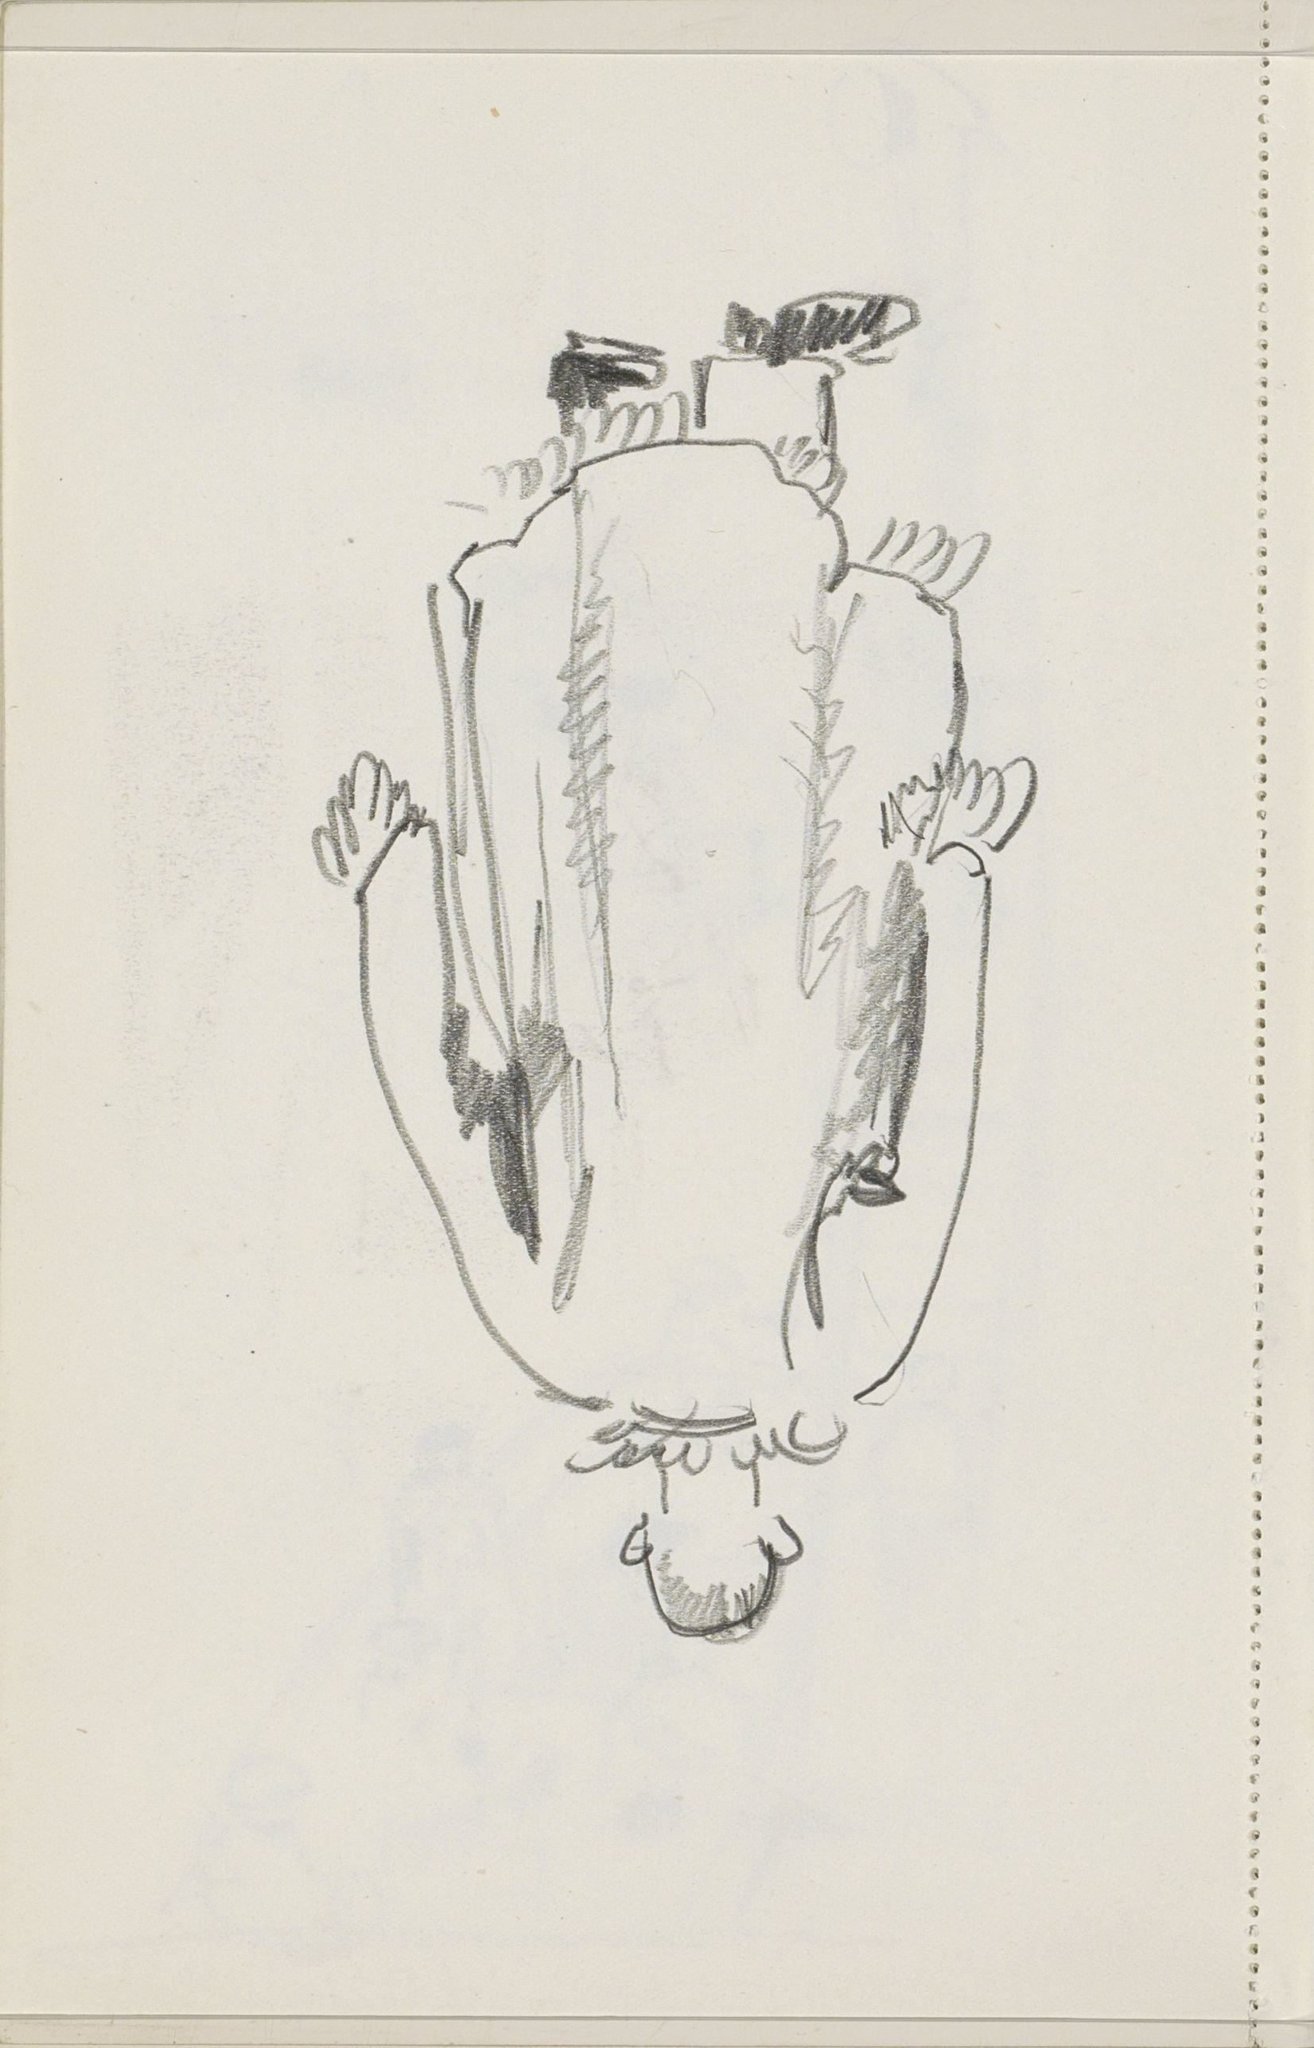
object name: sketchbook leaf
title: Staande man in een enkellange overjas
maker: cornelis vreedenburgh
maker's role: draughtsman, print maker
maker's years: 1880-1946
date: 1935-1936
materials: paper, pencil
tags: standing figure, coat: overcoat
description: Blad 55 verso uit een schetsboek met 73 bladen.